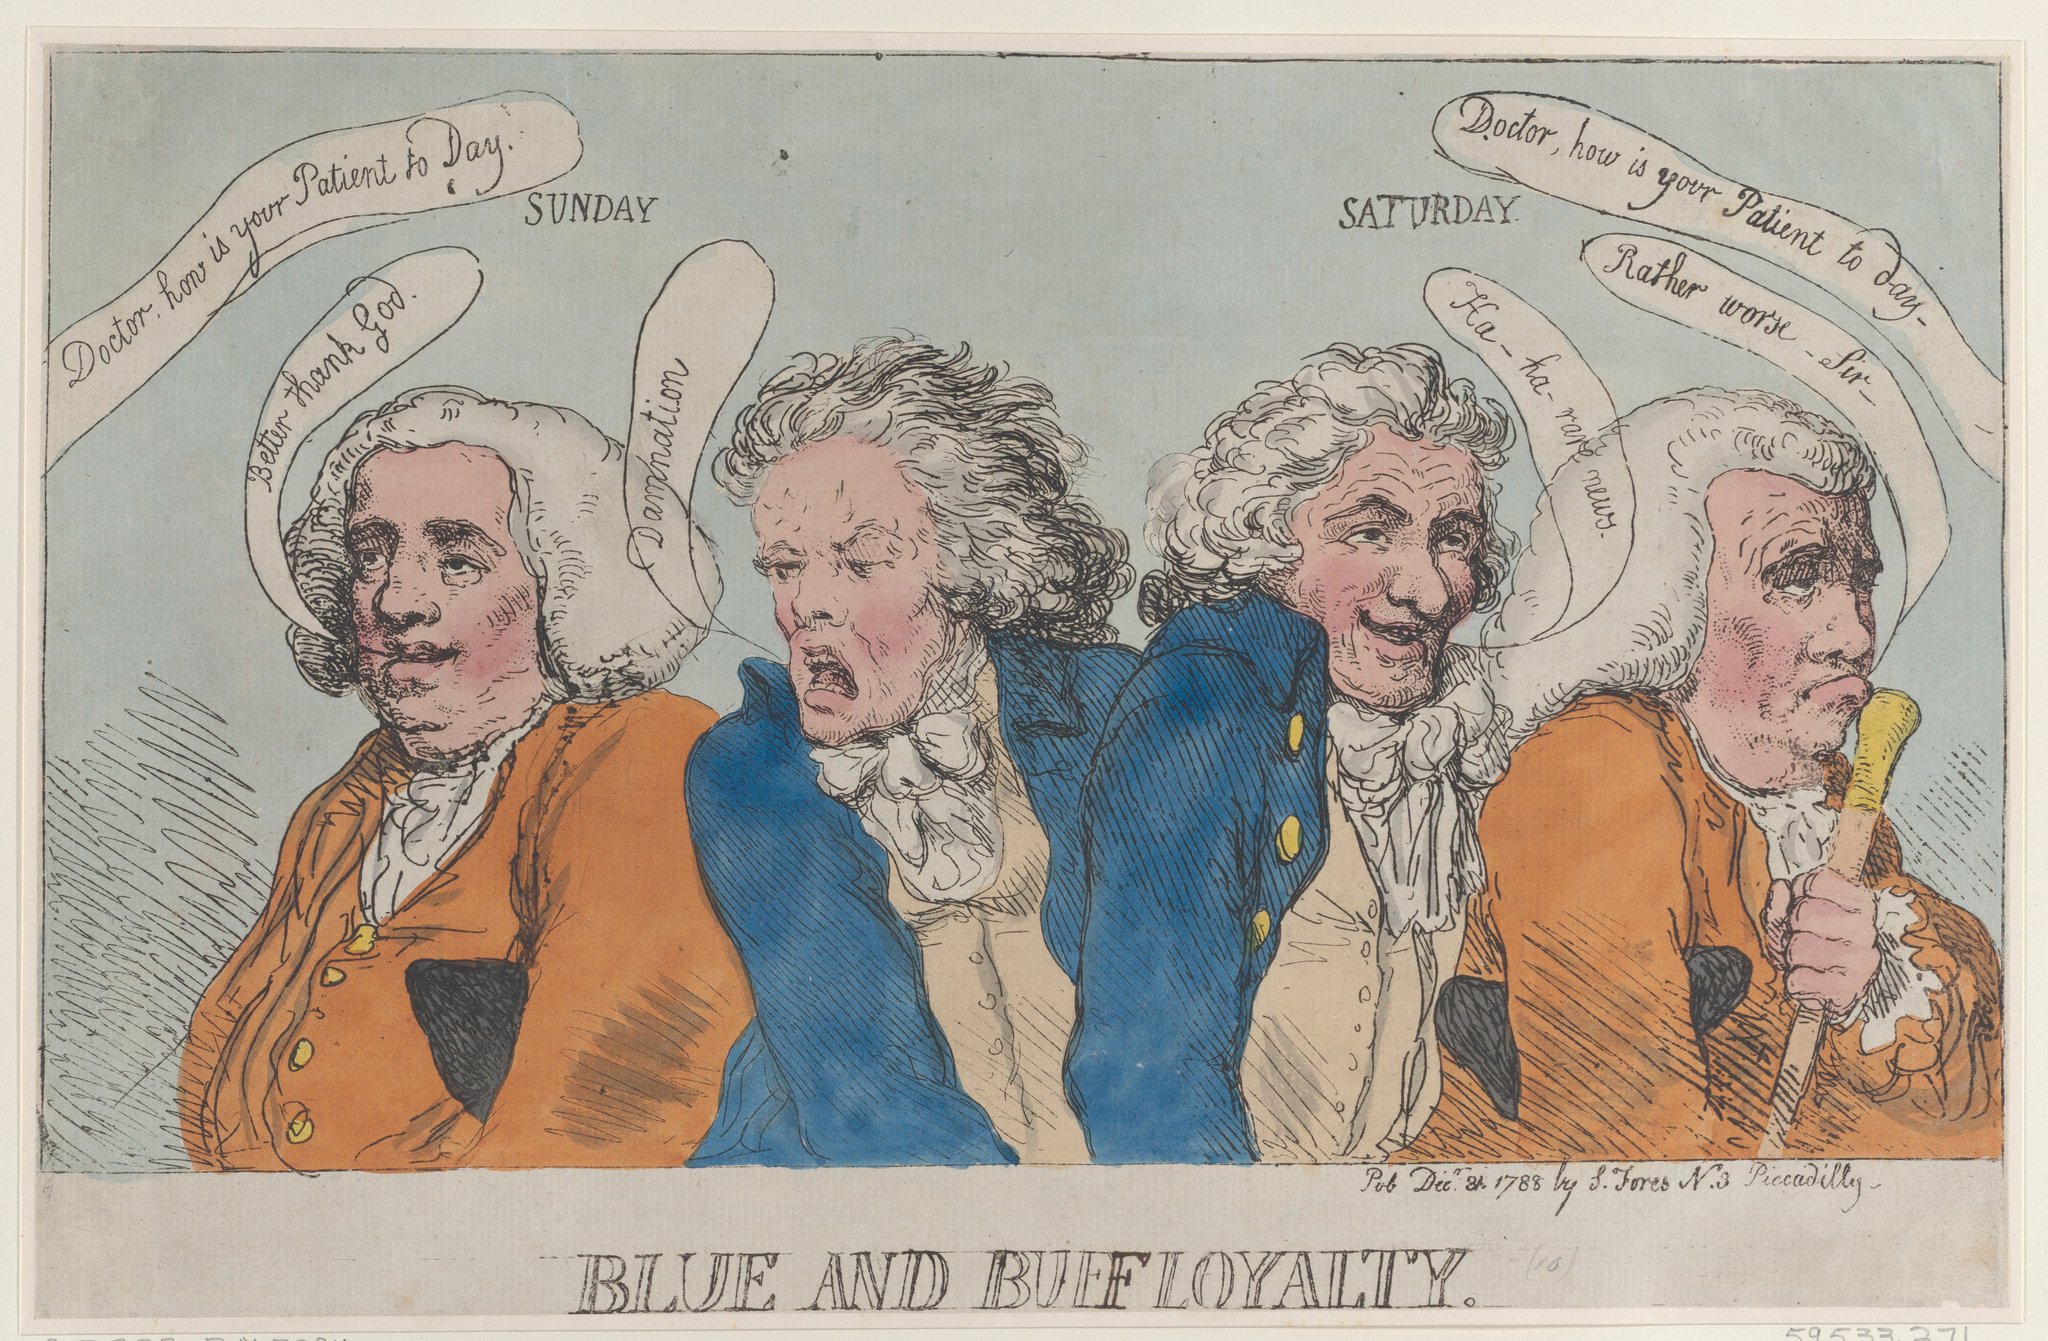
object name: print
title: Blue and Buff Loyalty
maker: thomas rowlandson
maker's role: artist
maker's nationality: british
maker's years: 1757-1827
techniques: etching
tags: satire,men